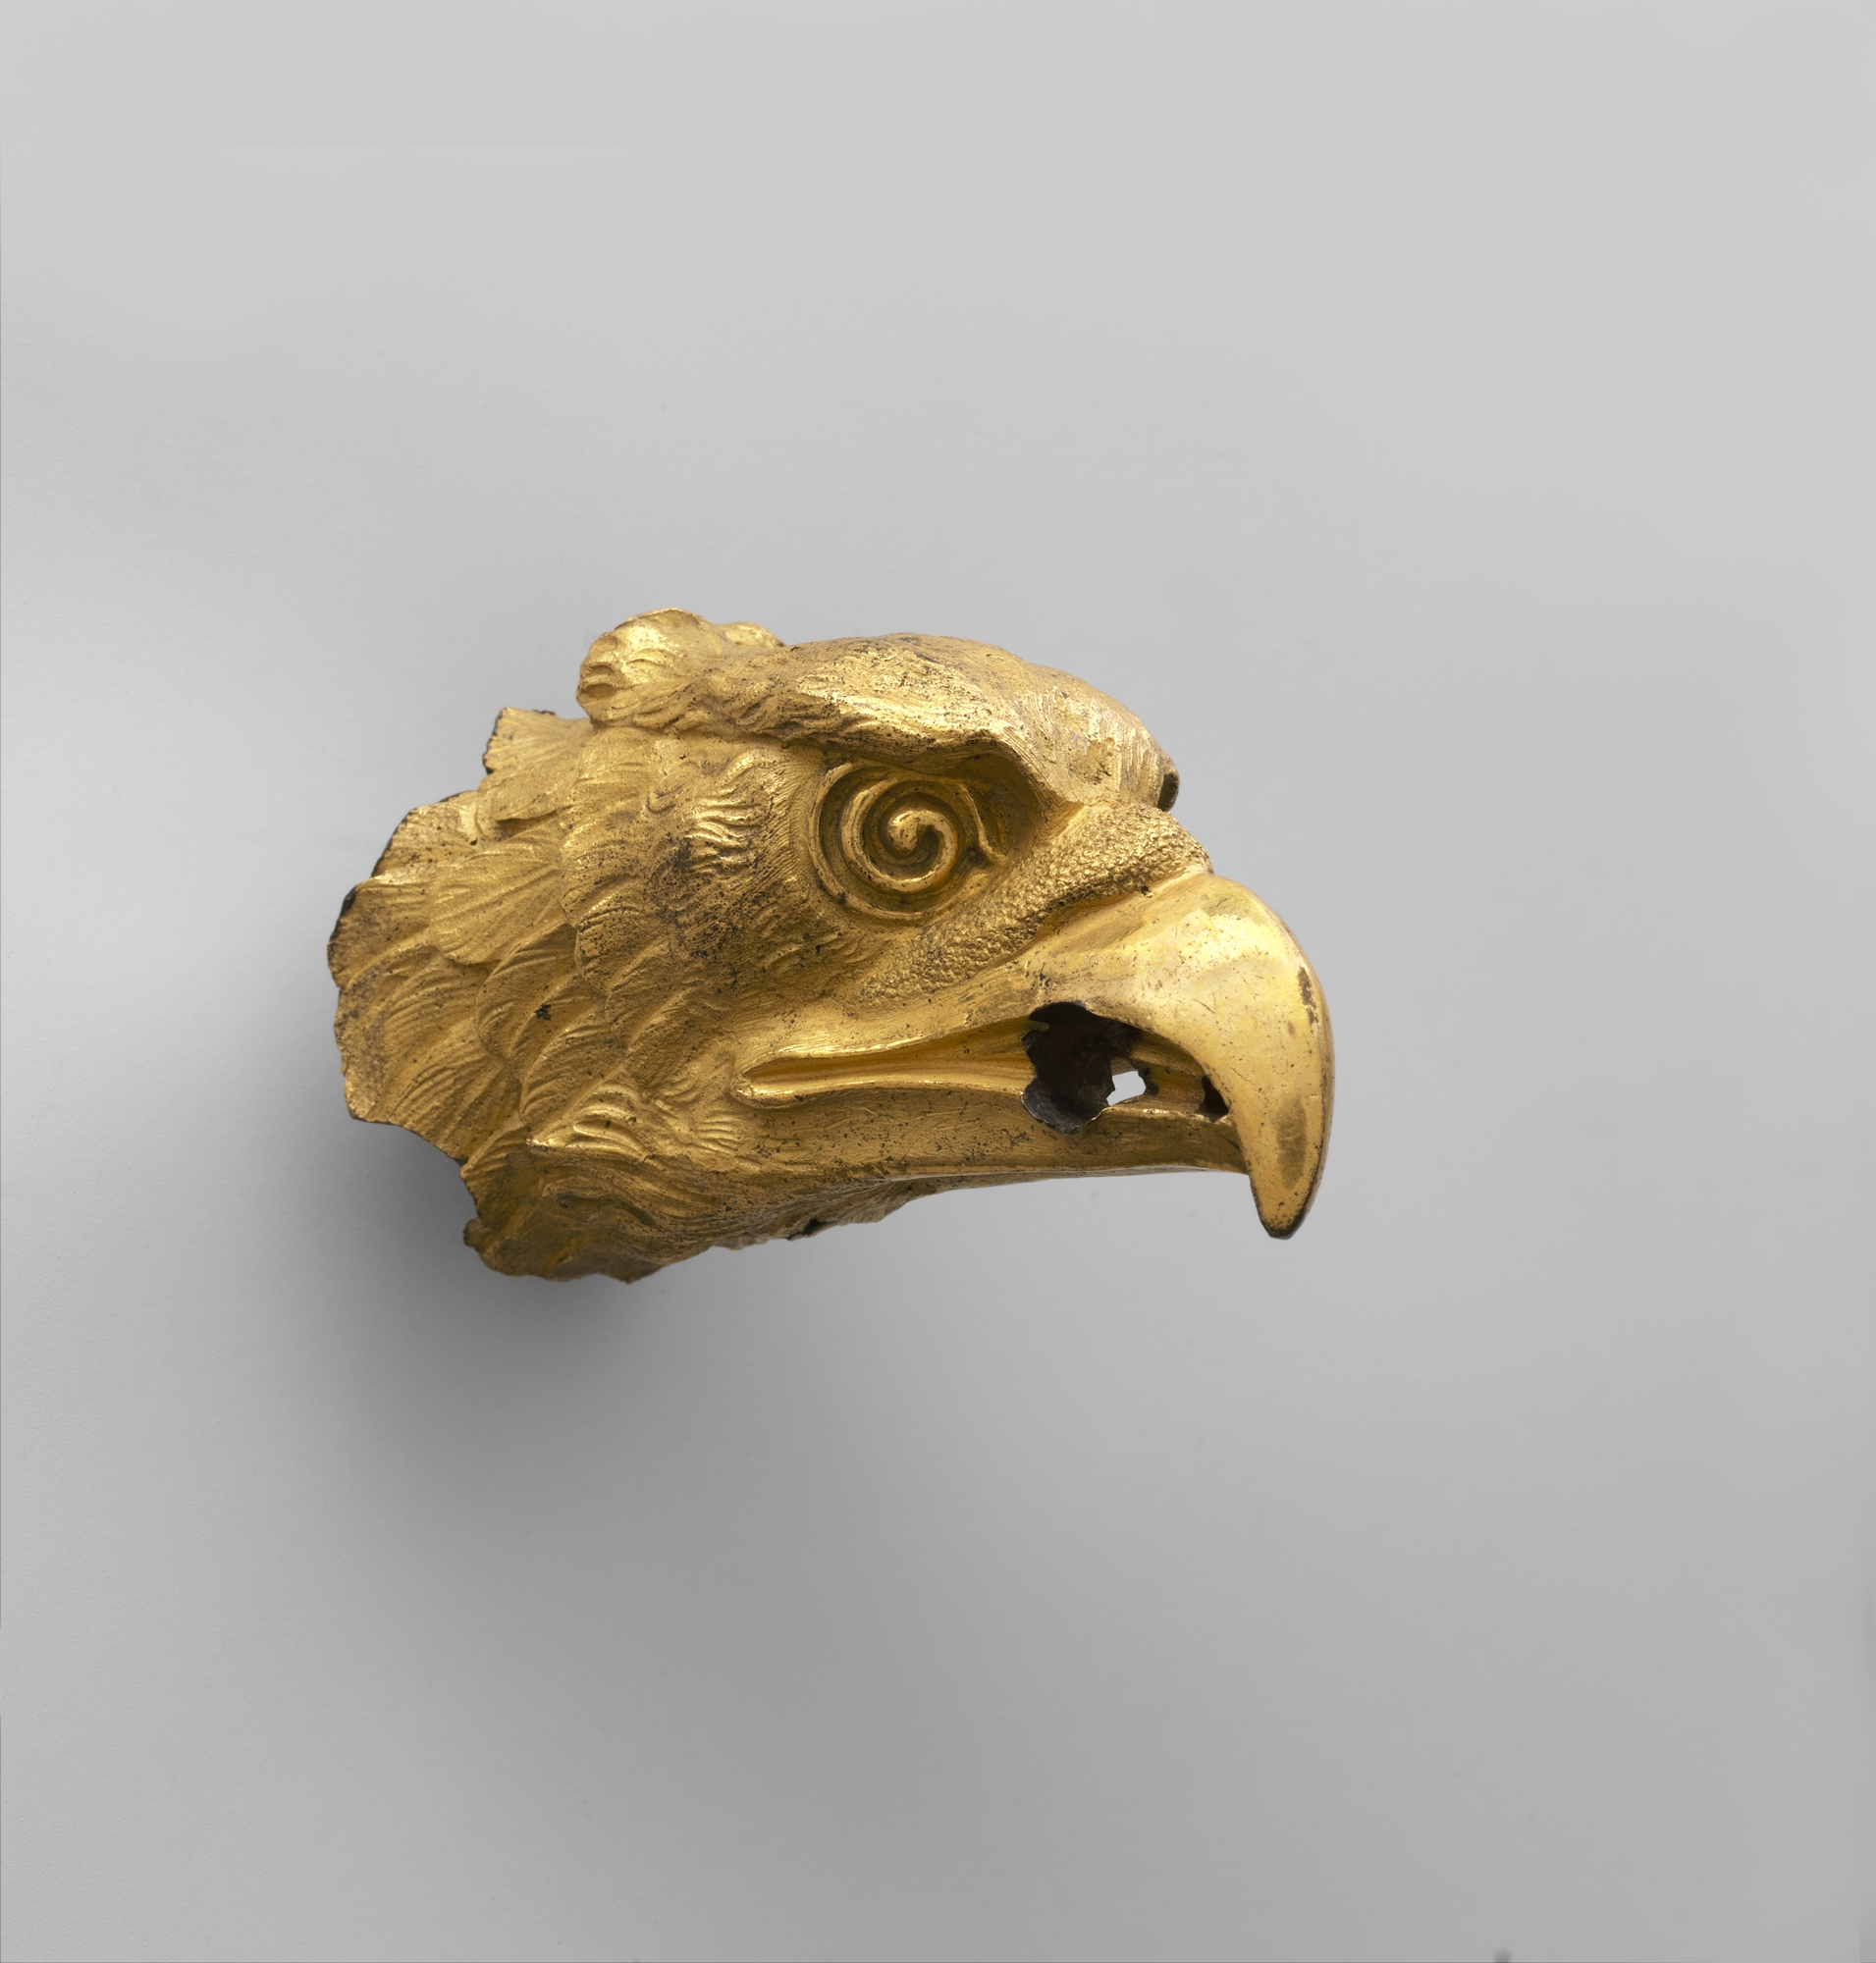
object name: ornament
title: Set of three ornaments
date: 1785-1790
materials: gilt bronze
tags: birds